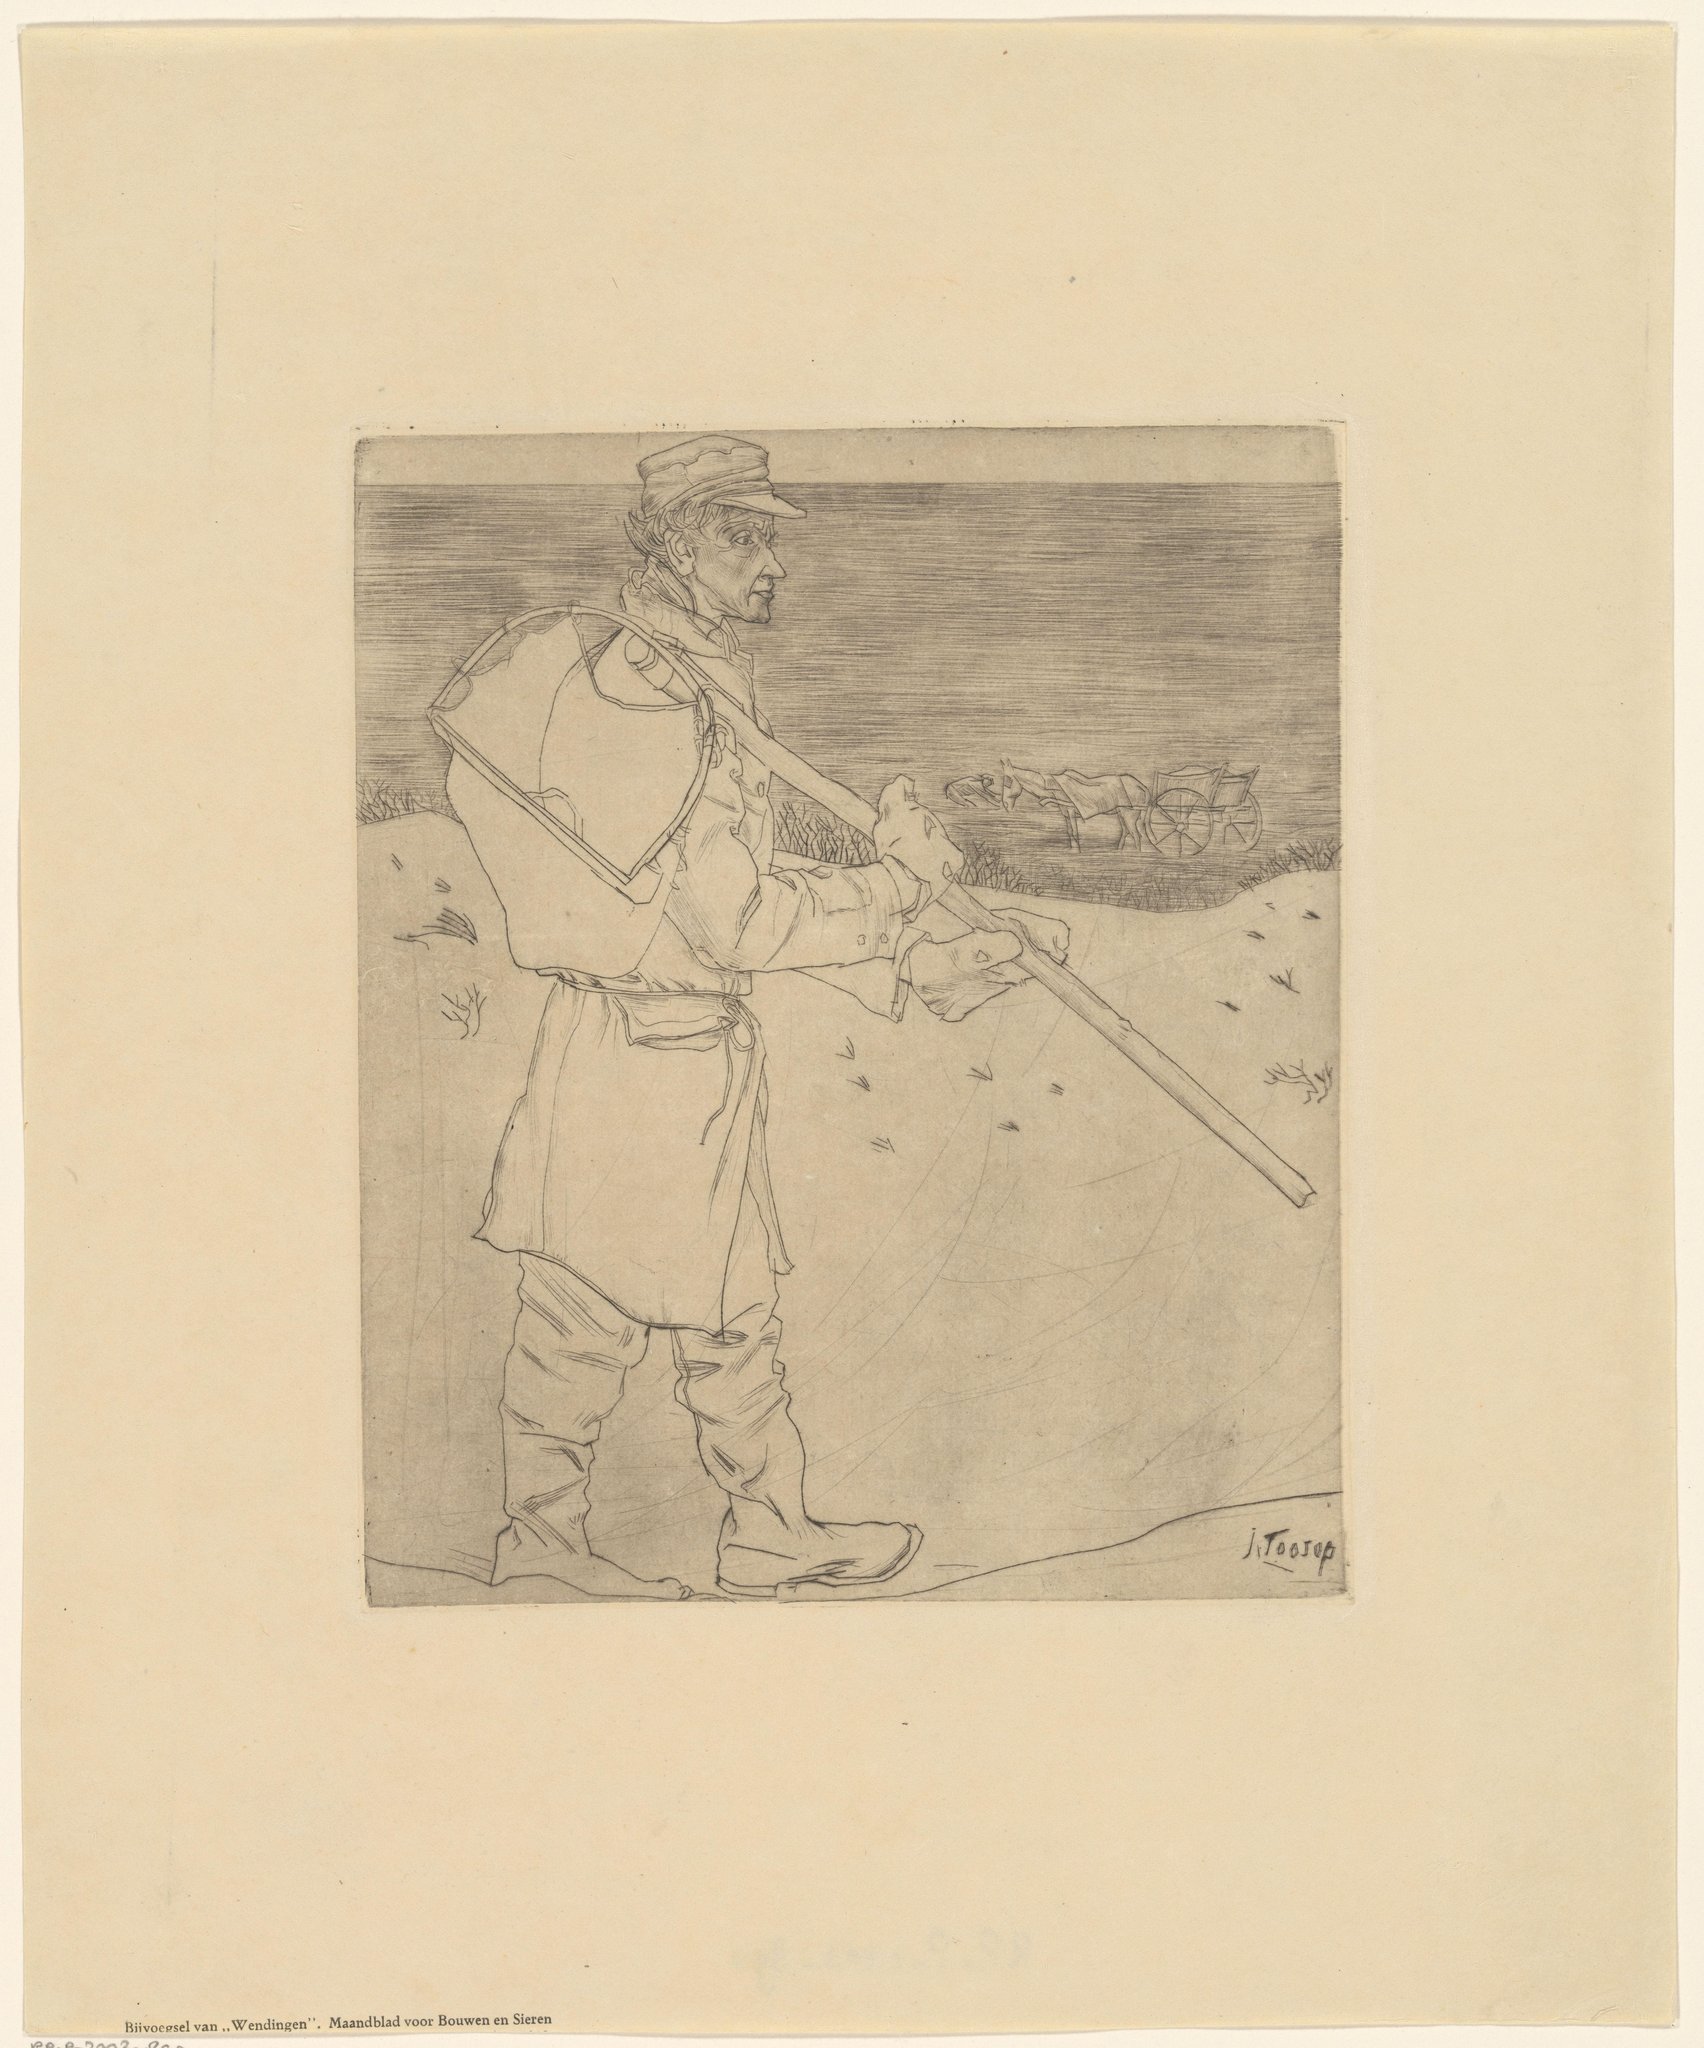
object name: print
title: De schelpenvisser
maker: jan toorop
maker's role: draughtsman, painter, print maker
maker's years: 1858-1928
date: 1902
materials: paper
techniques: drypoint, intaglio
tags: shell fishery, beach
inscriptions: collector's mark: Lugt 2228, annotation: ‘Bijvoegsel van "Wendingen". Maandblad voor Bouwen en Sieren’